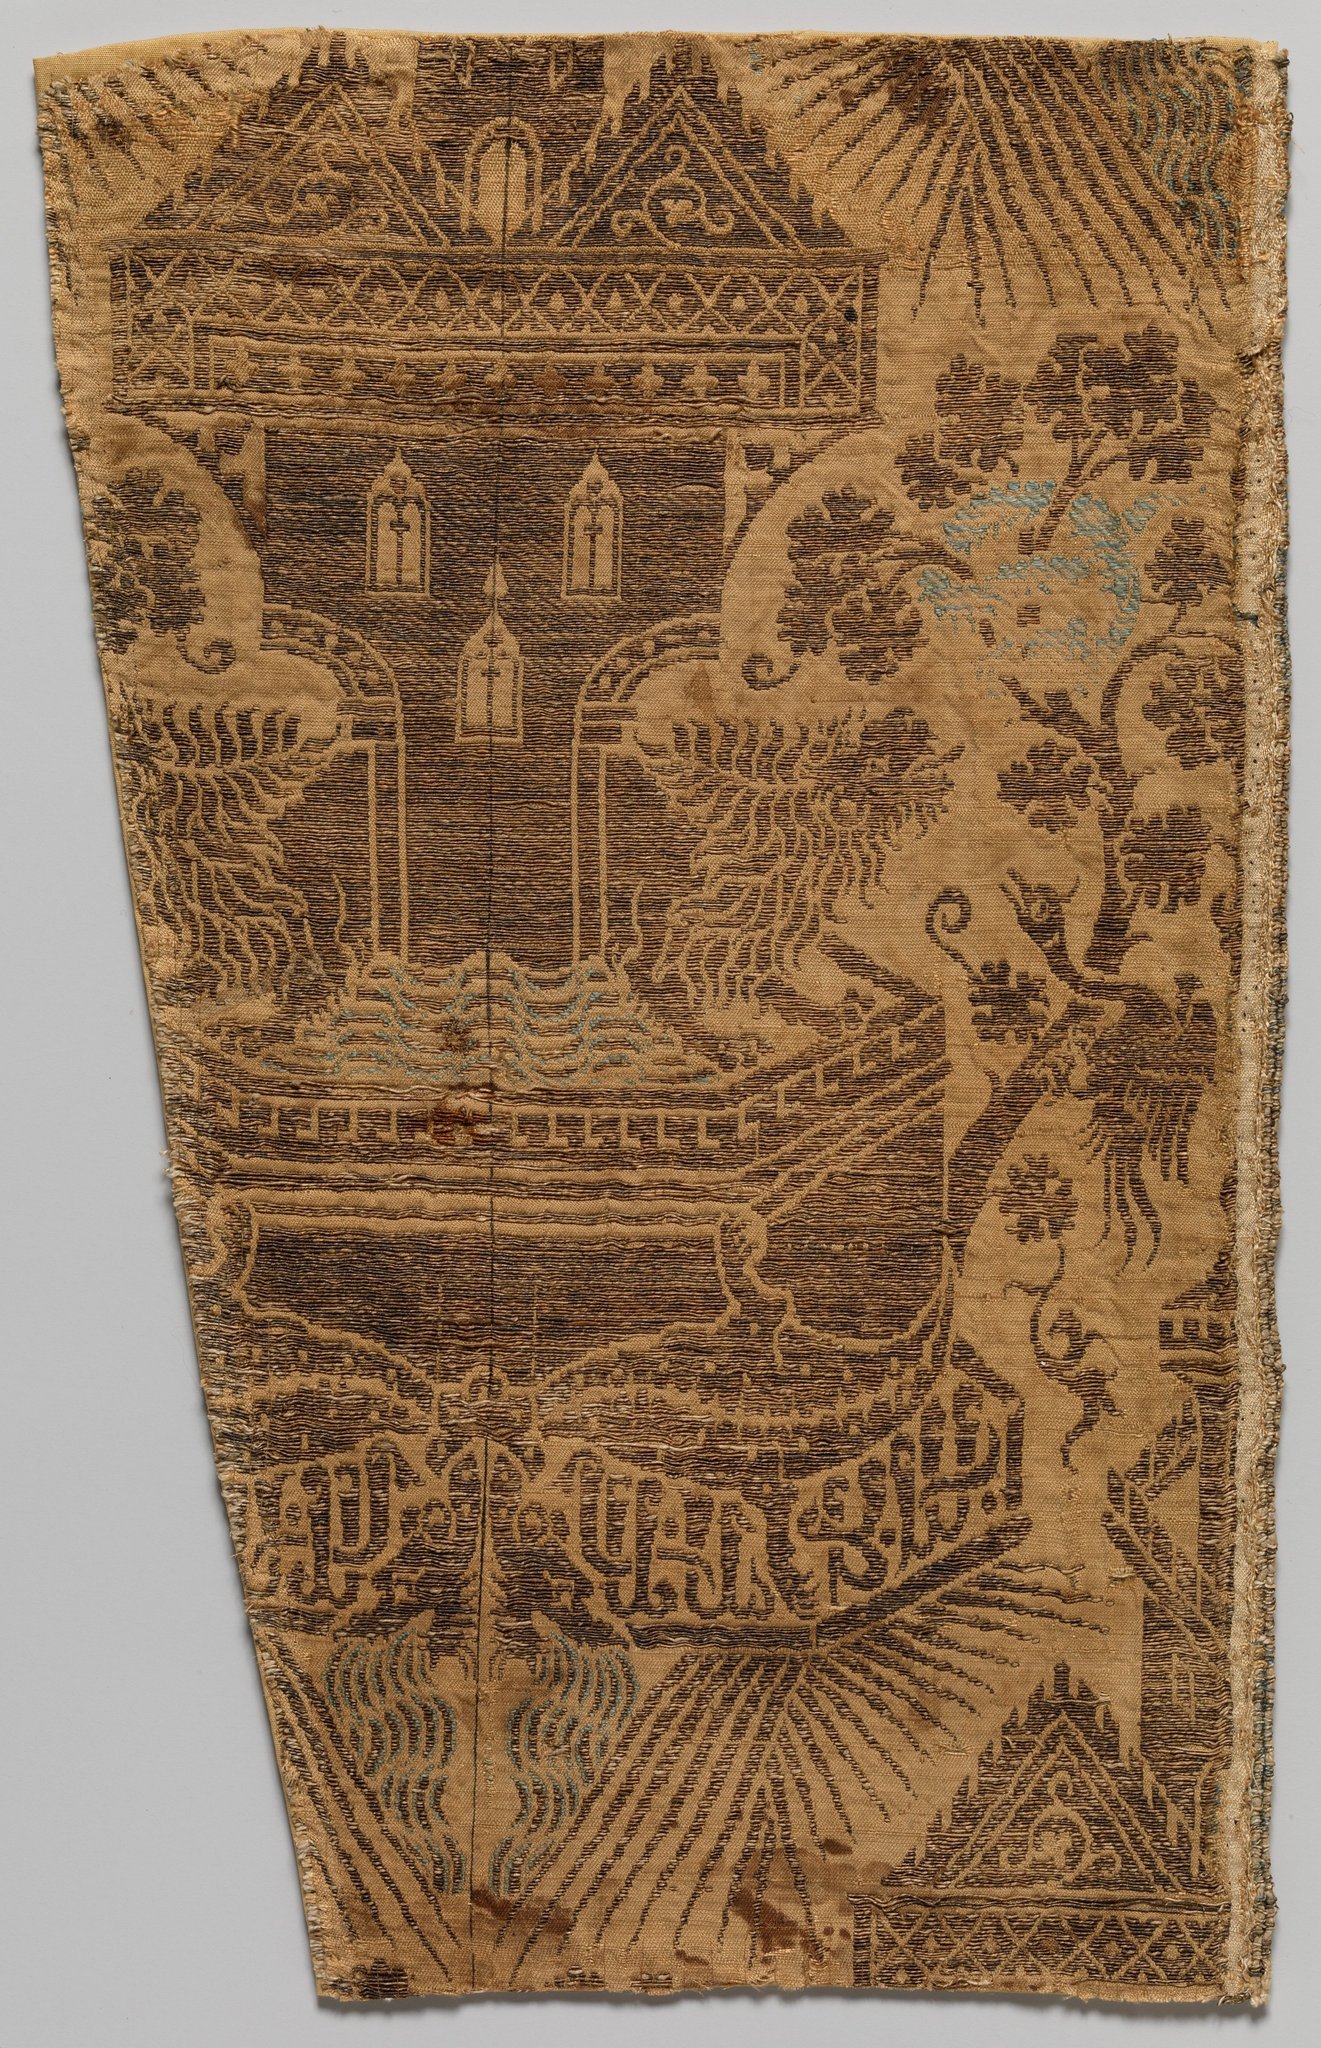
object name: textile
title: Textile with Architectural Fountain Guarded by Lions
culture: italian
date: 1301-1400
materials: metal thread, silk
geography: lucca (?)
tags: fountains,lions